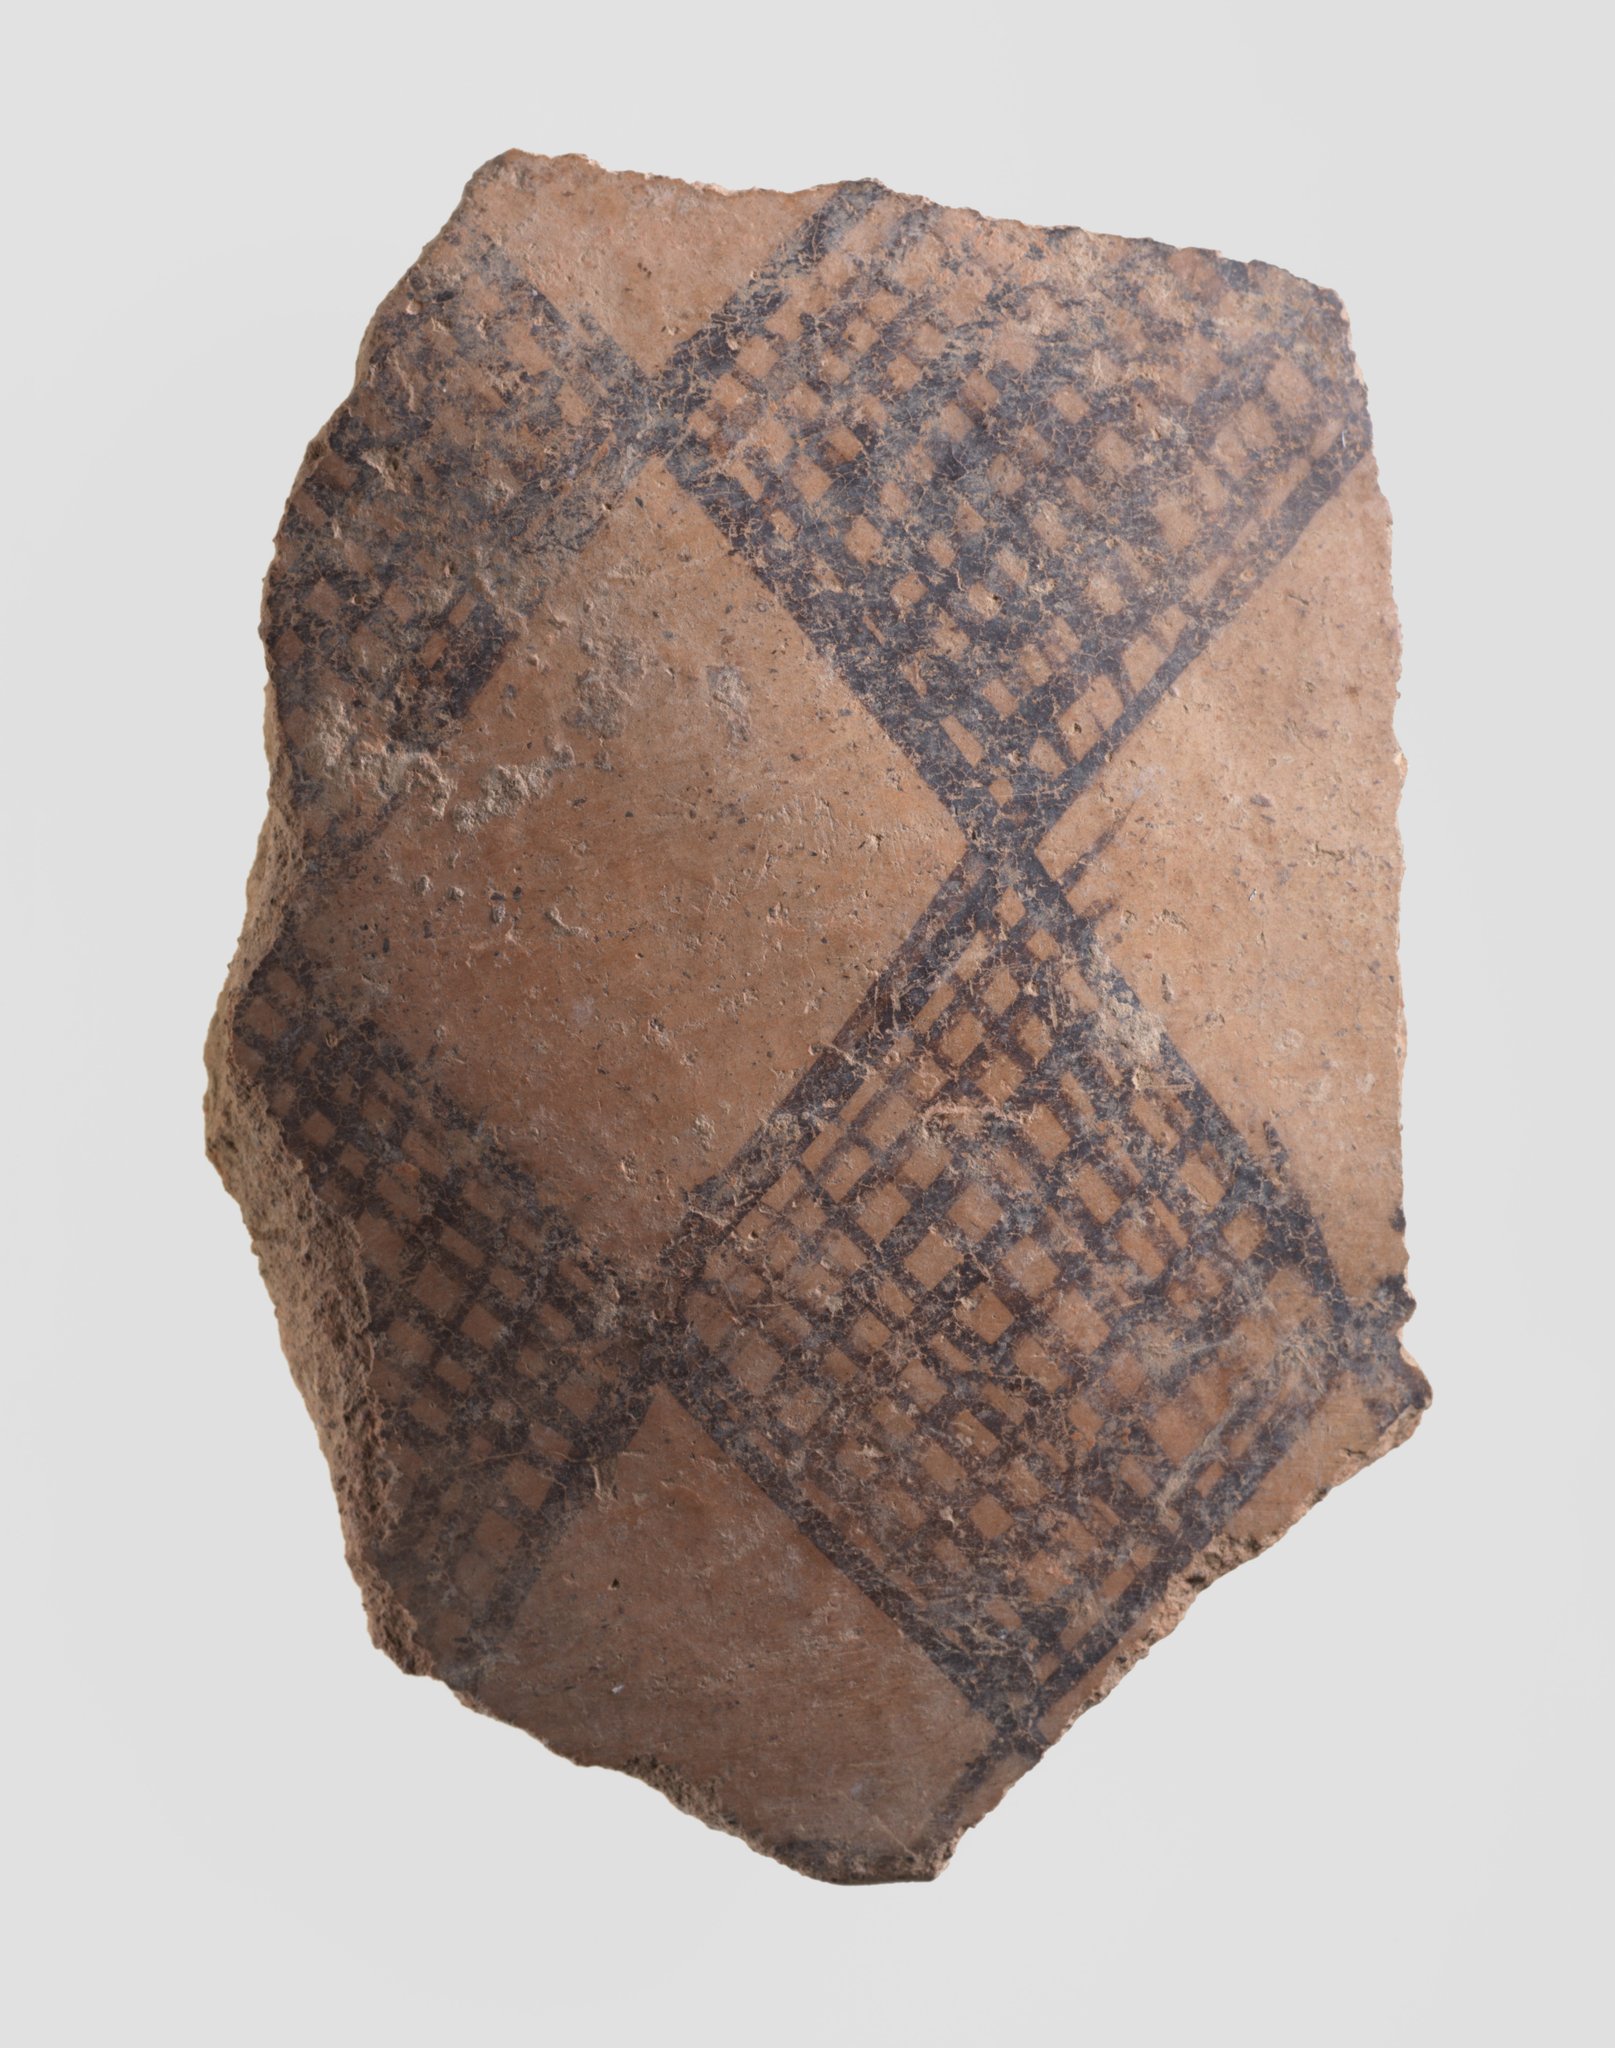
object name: sherd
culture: iranian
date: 1500-1000 BCE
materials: ceramic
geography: iran